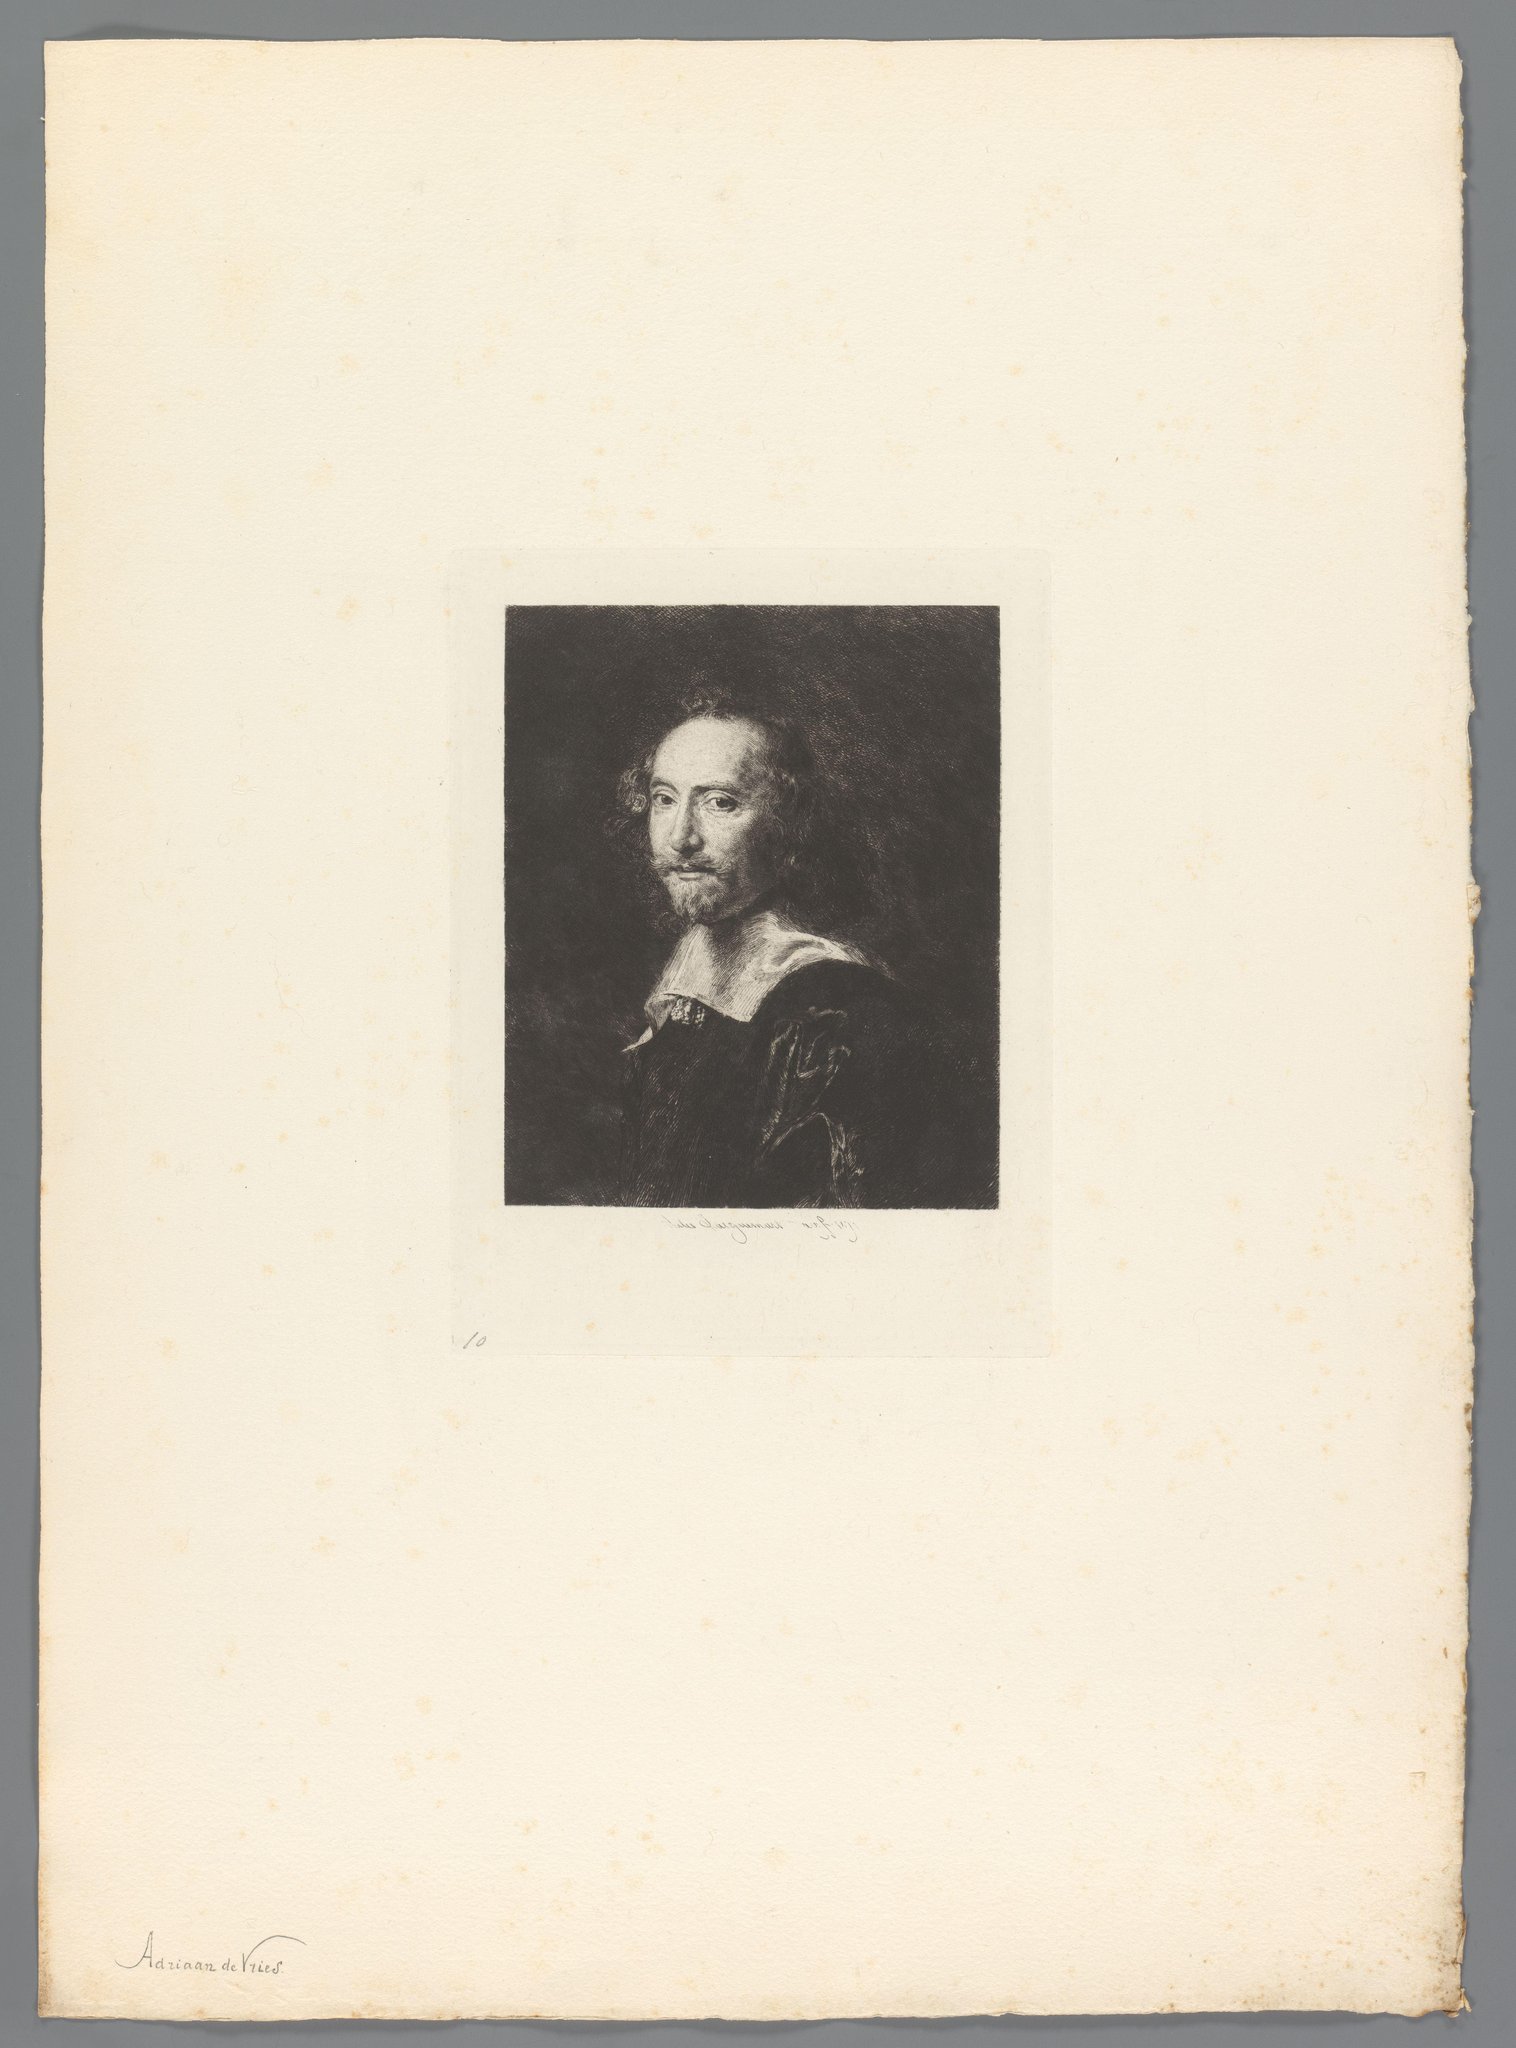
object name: print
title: Etsen naar schilderijen in The Metropolitan Museum of Art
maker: jules ferdinand jacquemart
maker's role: draughtsman, print maker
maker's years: 1837-1880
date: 1871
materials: paper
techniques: etching, intaglio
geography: london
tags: anonymous historical person portrayed alone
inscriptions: collector's mark: ‘Koninklijk Oudheidkundig Genootschap Amsterdam / Bibliotheek’, collector's mark: Lugt 2228, number: ‘10’, inscription: ‘Adriaan de Vries’